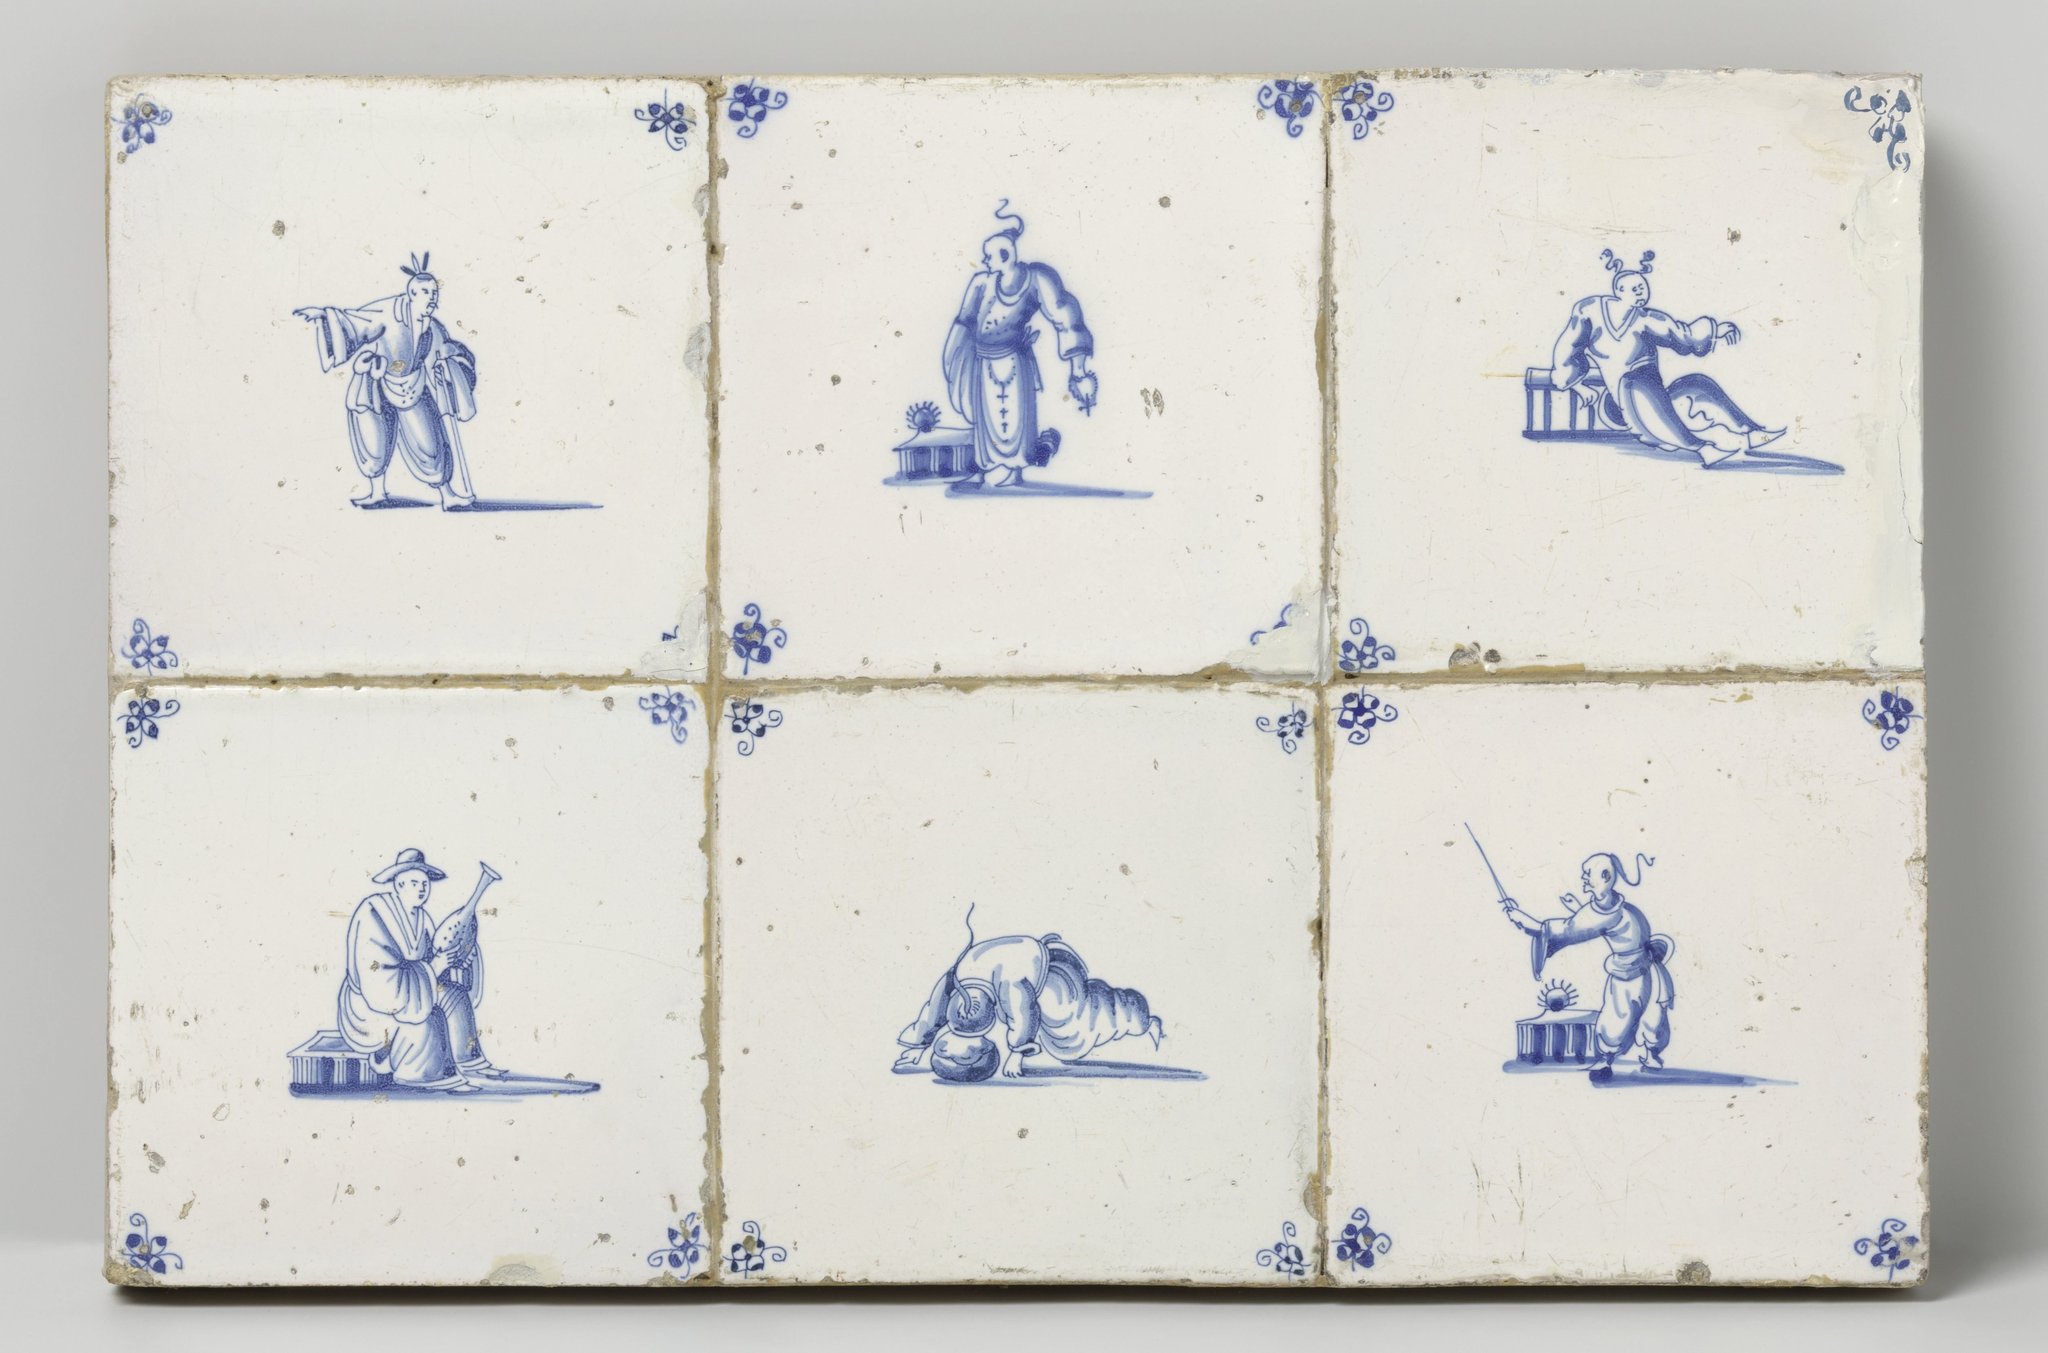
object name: tile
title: Veld van zes tegels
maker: Anonymous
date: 1660-1690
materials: earthenware, glaze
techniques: maiolica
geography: netherlands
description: Veld van 6 tegels (2 x 3) elk met een blauw geschilderde Chinees met in de hoeken, een spinnetje.